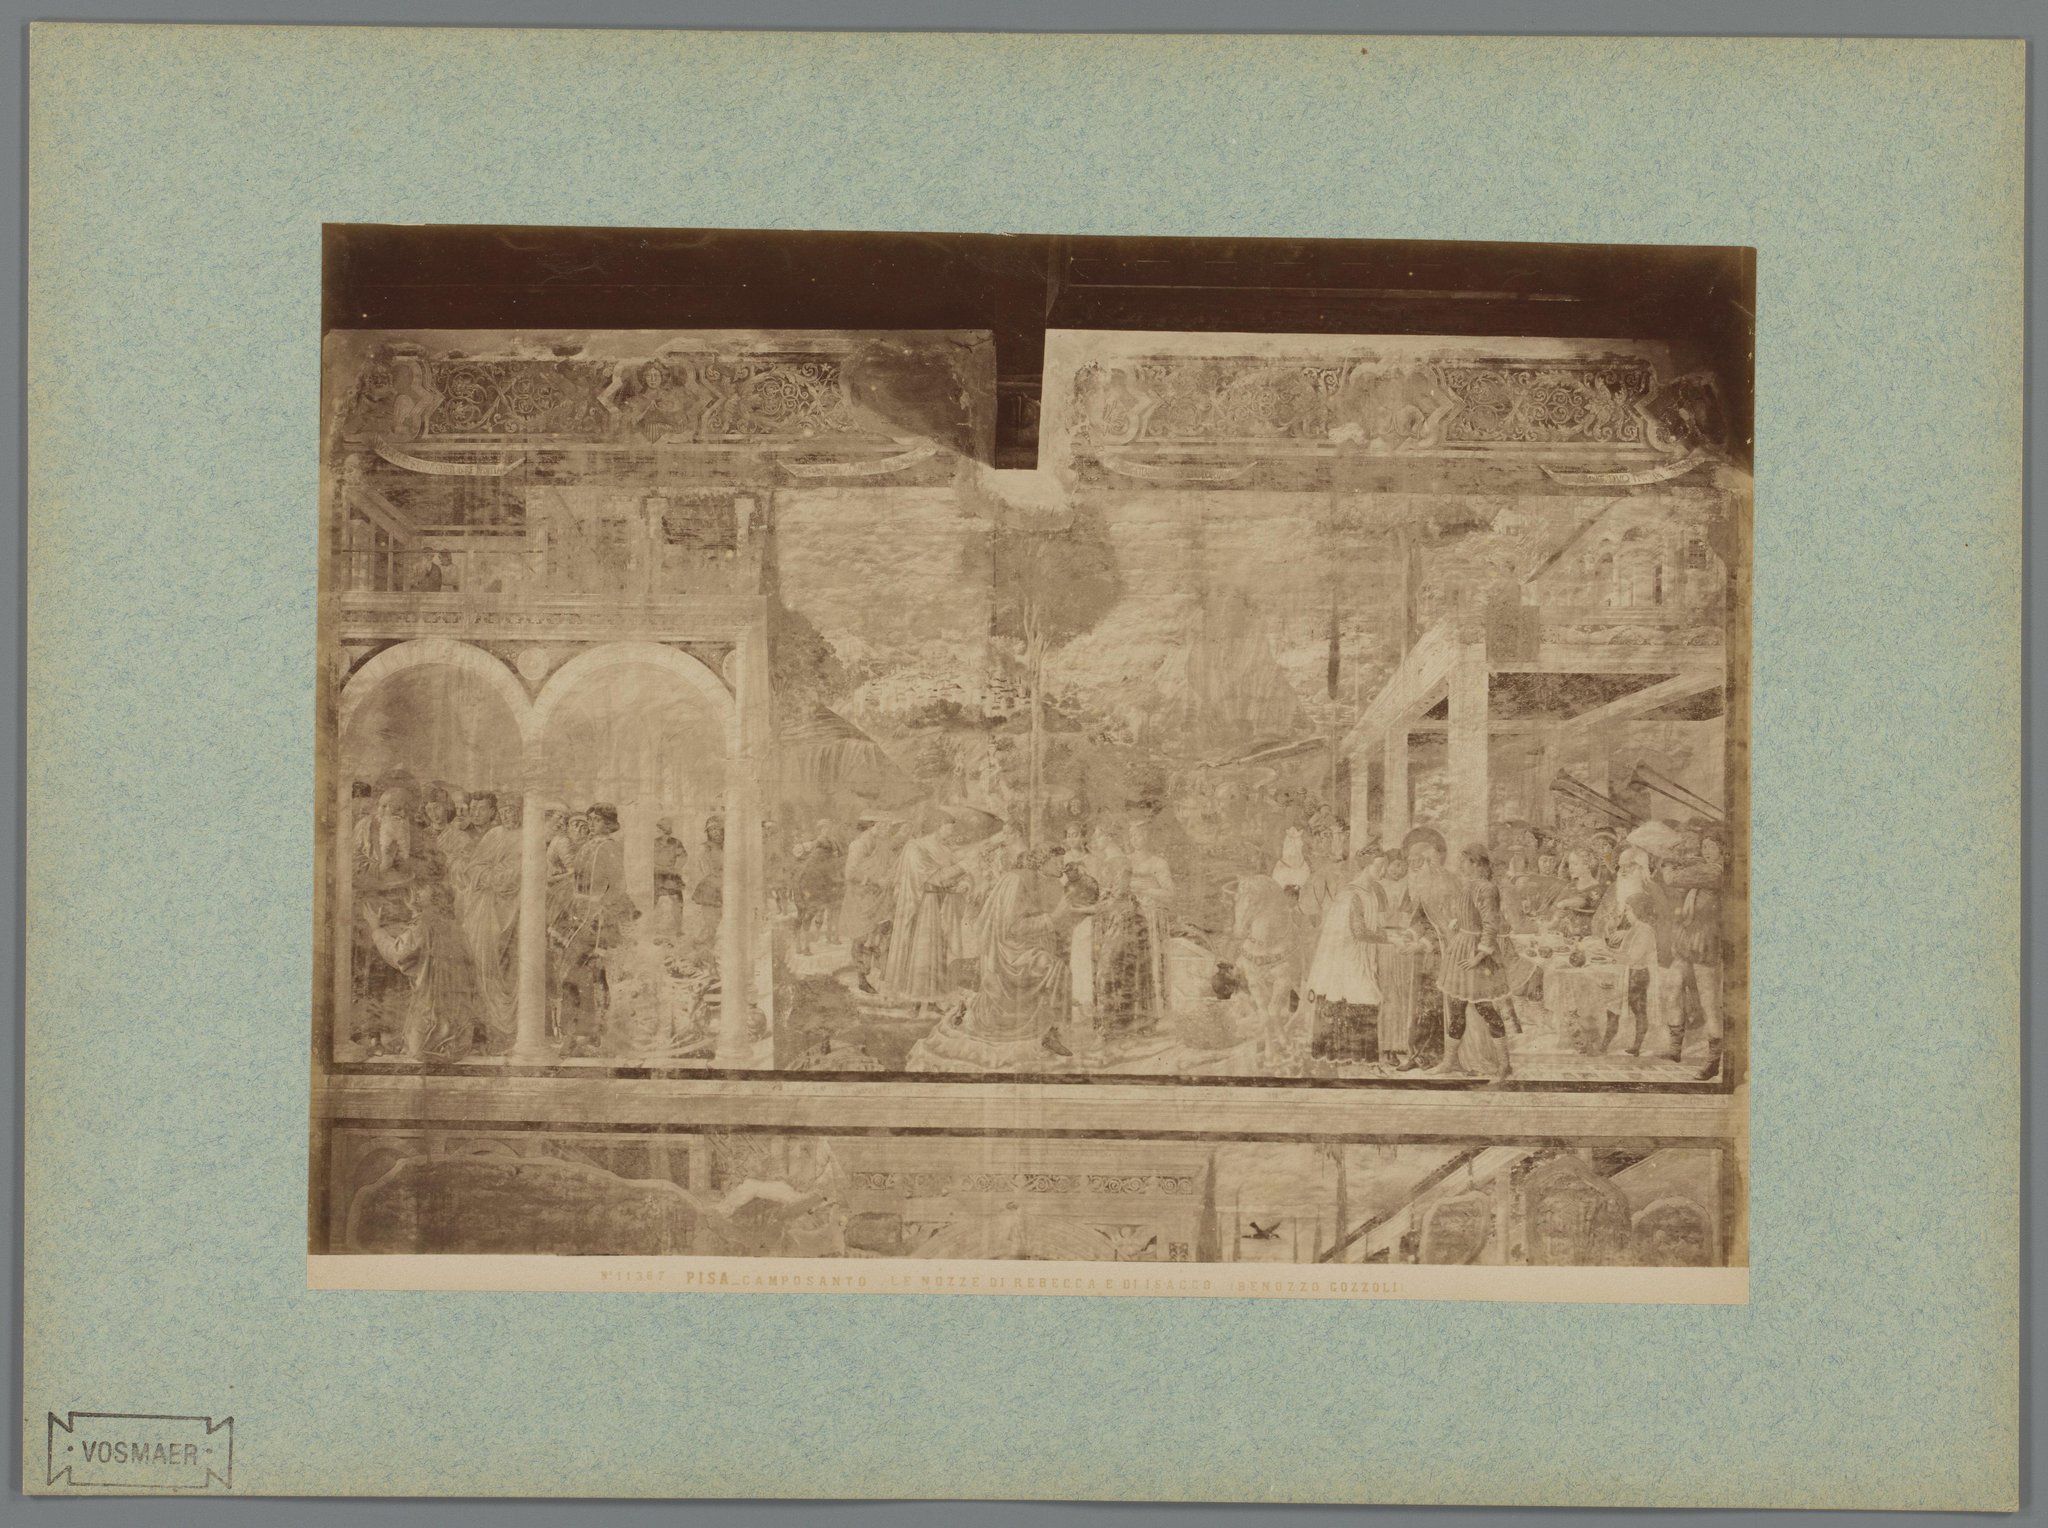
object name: reproduction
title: Pisa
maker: benozzo gozzoli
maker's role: draughtsman, painter, sculptor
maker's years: 1421-1497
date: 1852-1900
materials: cardboard, paper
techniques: albumen print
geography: pisa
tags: rebekah (rebecca) sought in marriage (genesis 24), wall-covering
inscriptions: number: ‘No. 11367’, collector's mark: ‘VOSMAER’